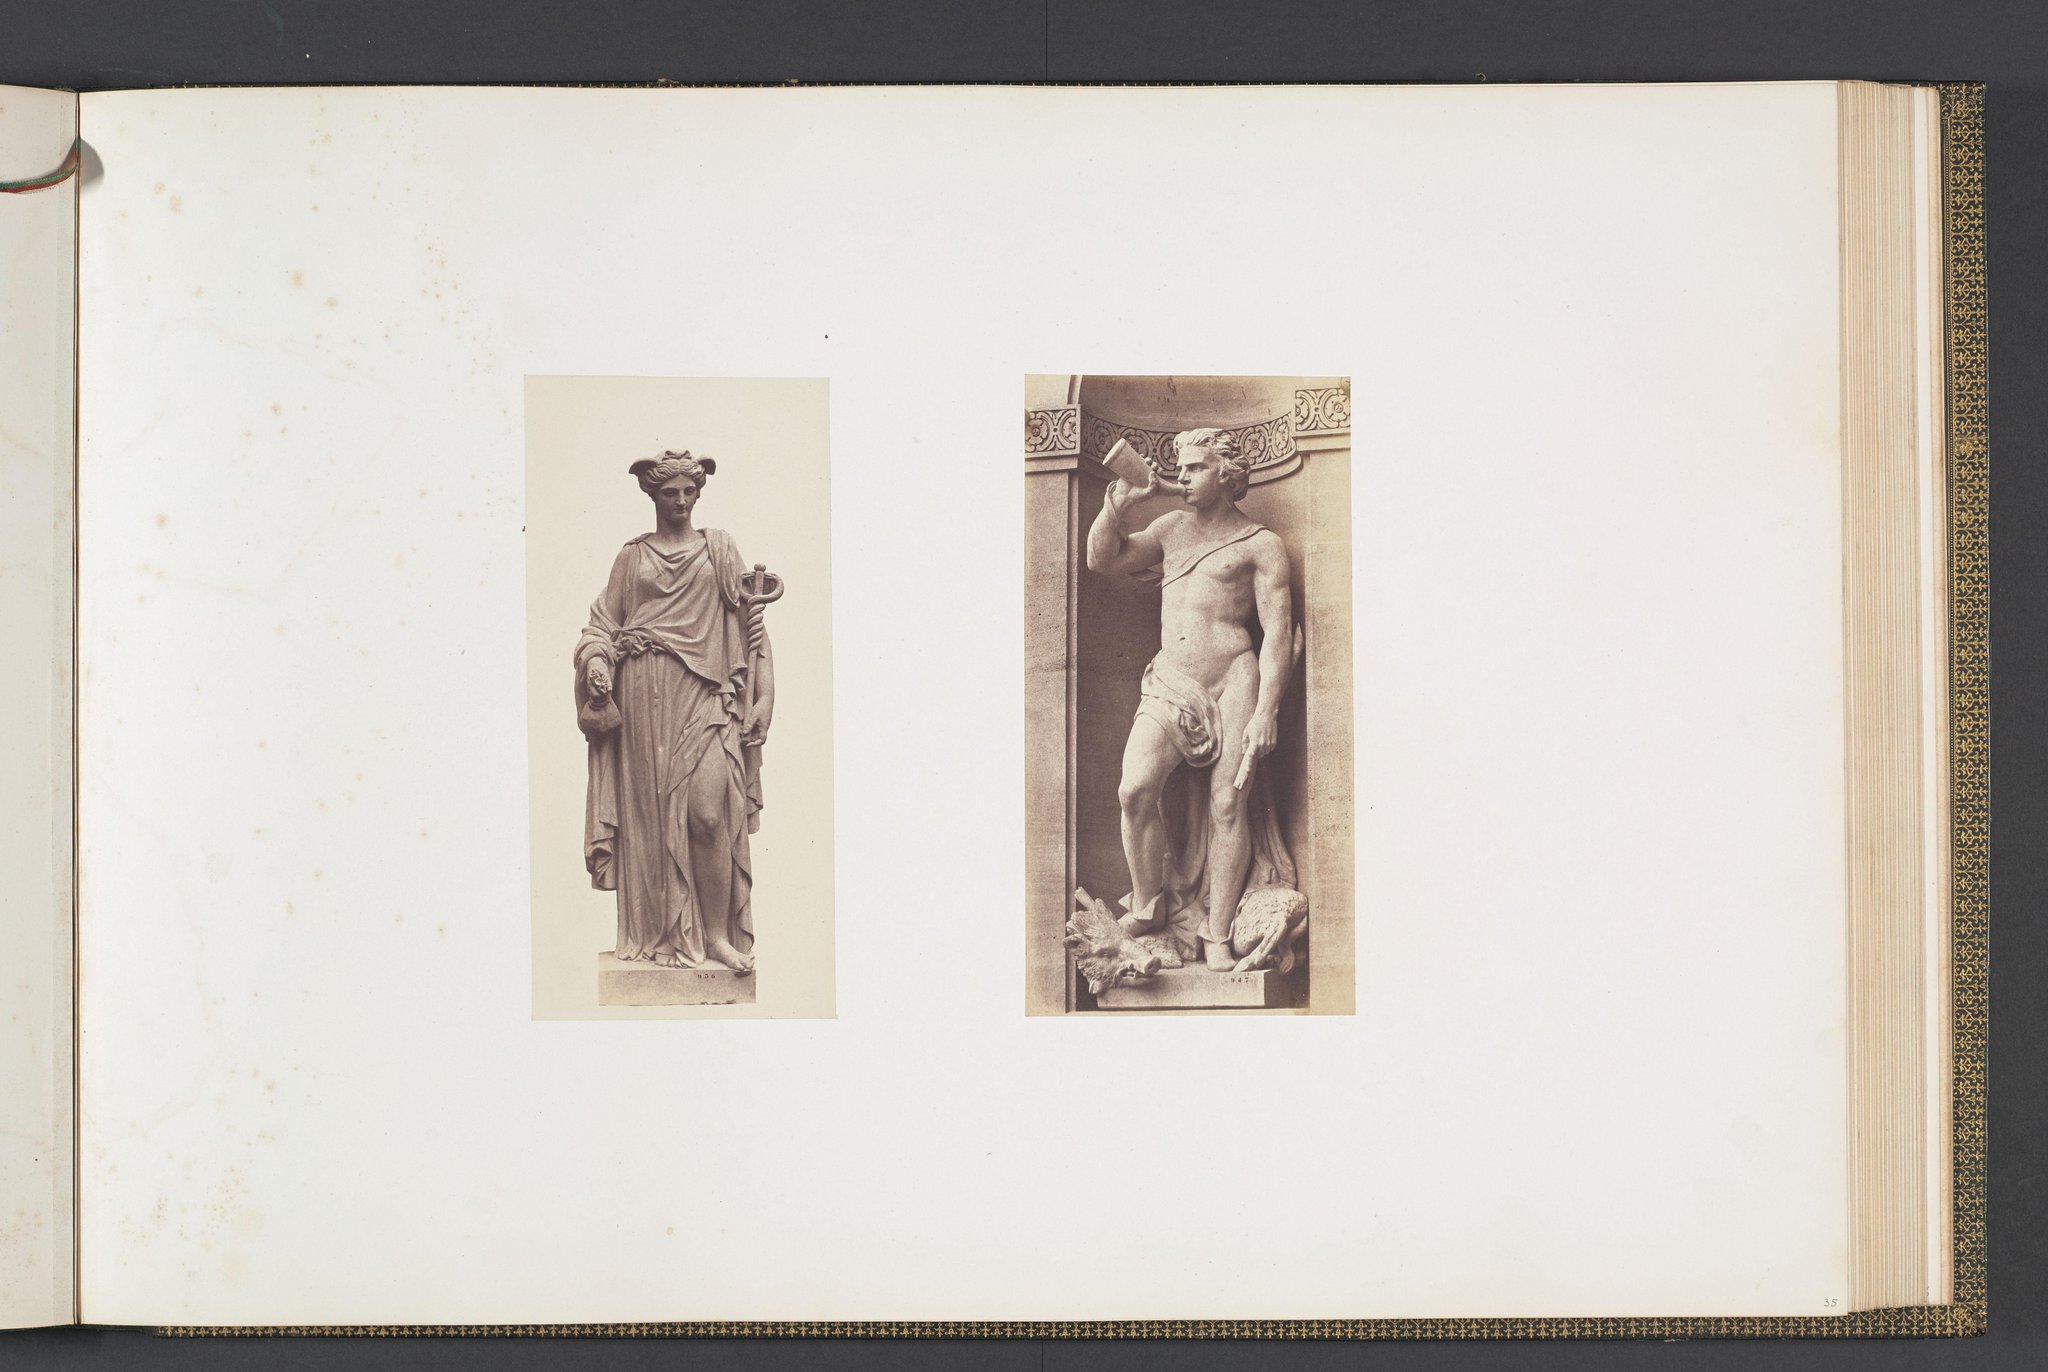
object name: album leaf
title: Gipsmodellen voor beeldhouwwerken op het Palais du Louvre: links "Le Commerce" door Gustave Crauk en rechts "Le Chasseur" door Armand Blanc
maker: édouard denis baldus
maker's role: fotograaf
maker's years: 1813-1889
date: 1855-1857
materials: paper, photographic support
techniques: salted paper print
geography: paris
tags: piece of sculpture, reproduction of a piece of sculpture, permanent exhibition, museum, paris, tuileries palace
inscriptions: number: ‘936 en 947’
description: Onderdeel van Réunion des Tuileries au Louvre 1852-1857, album 3.